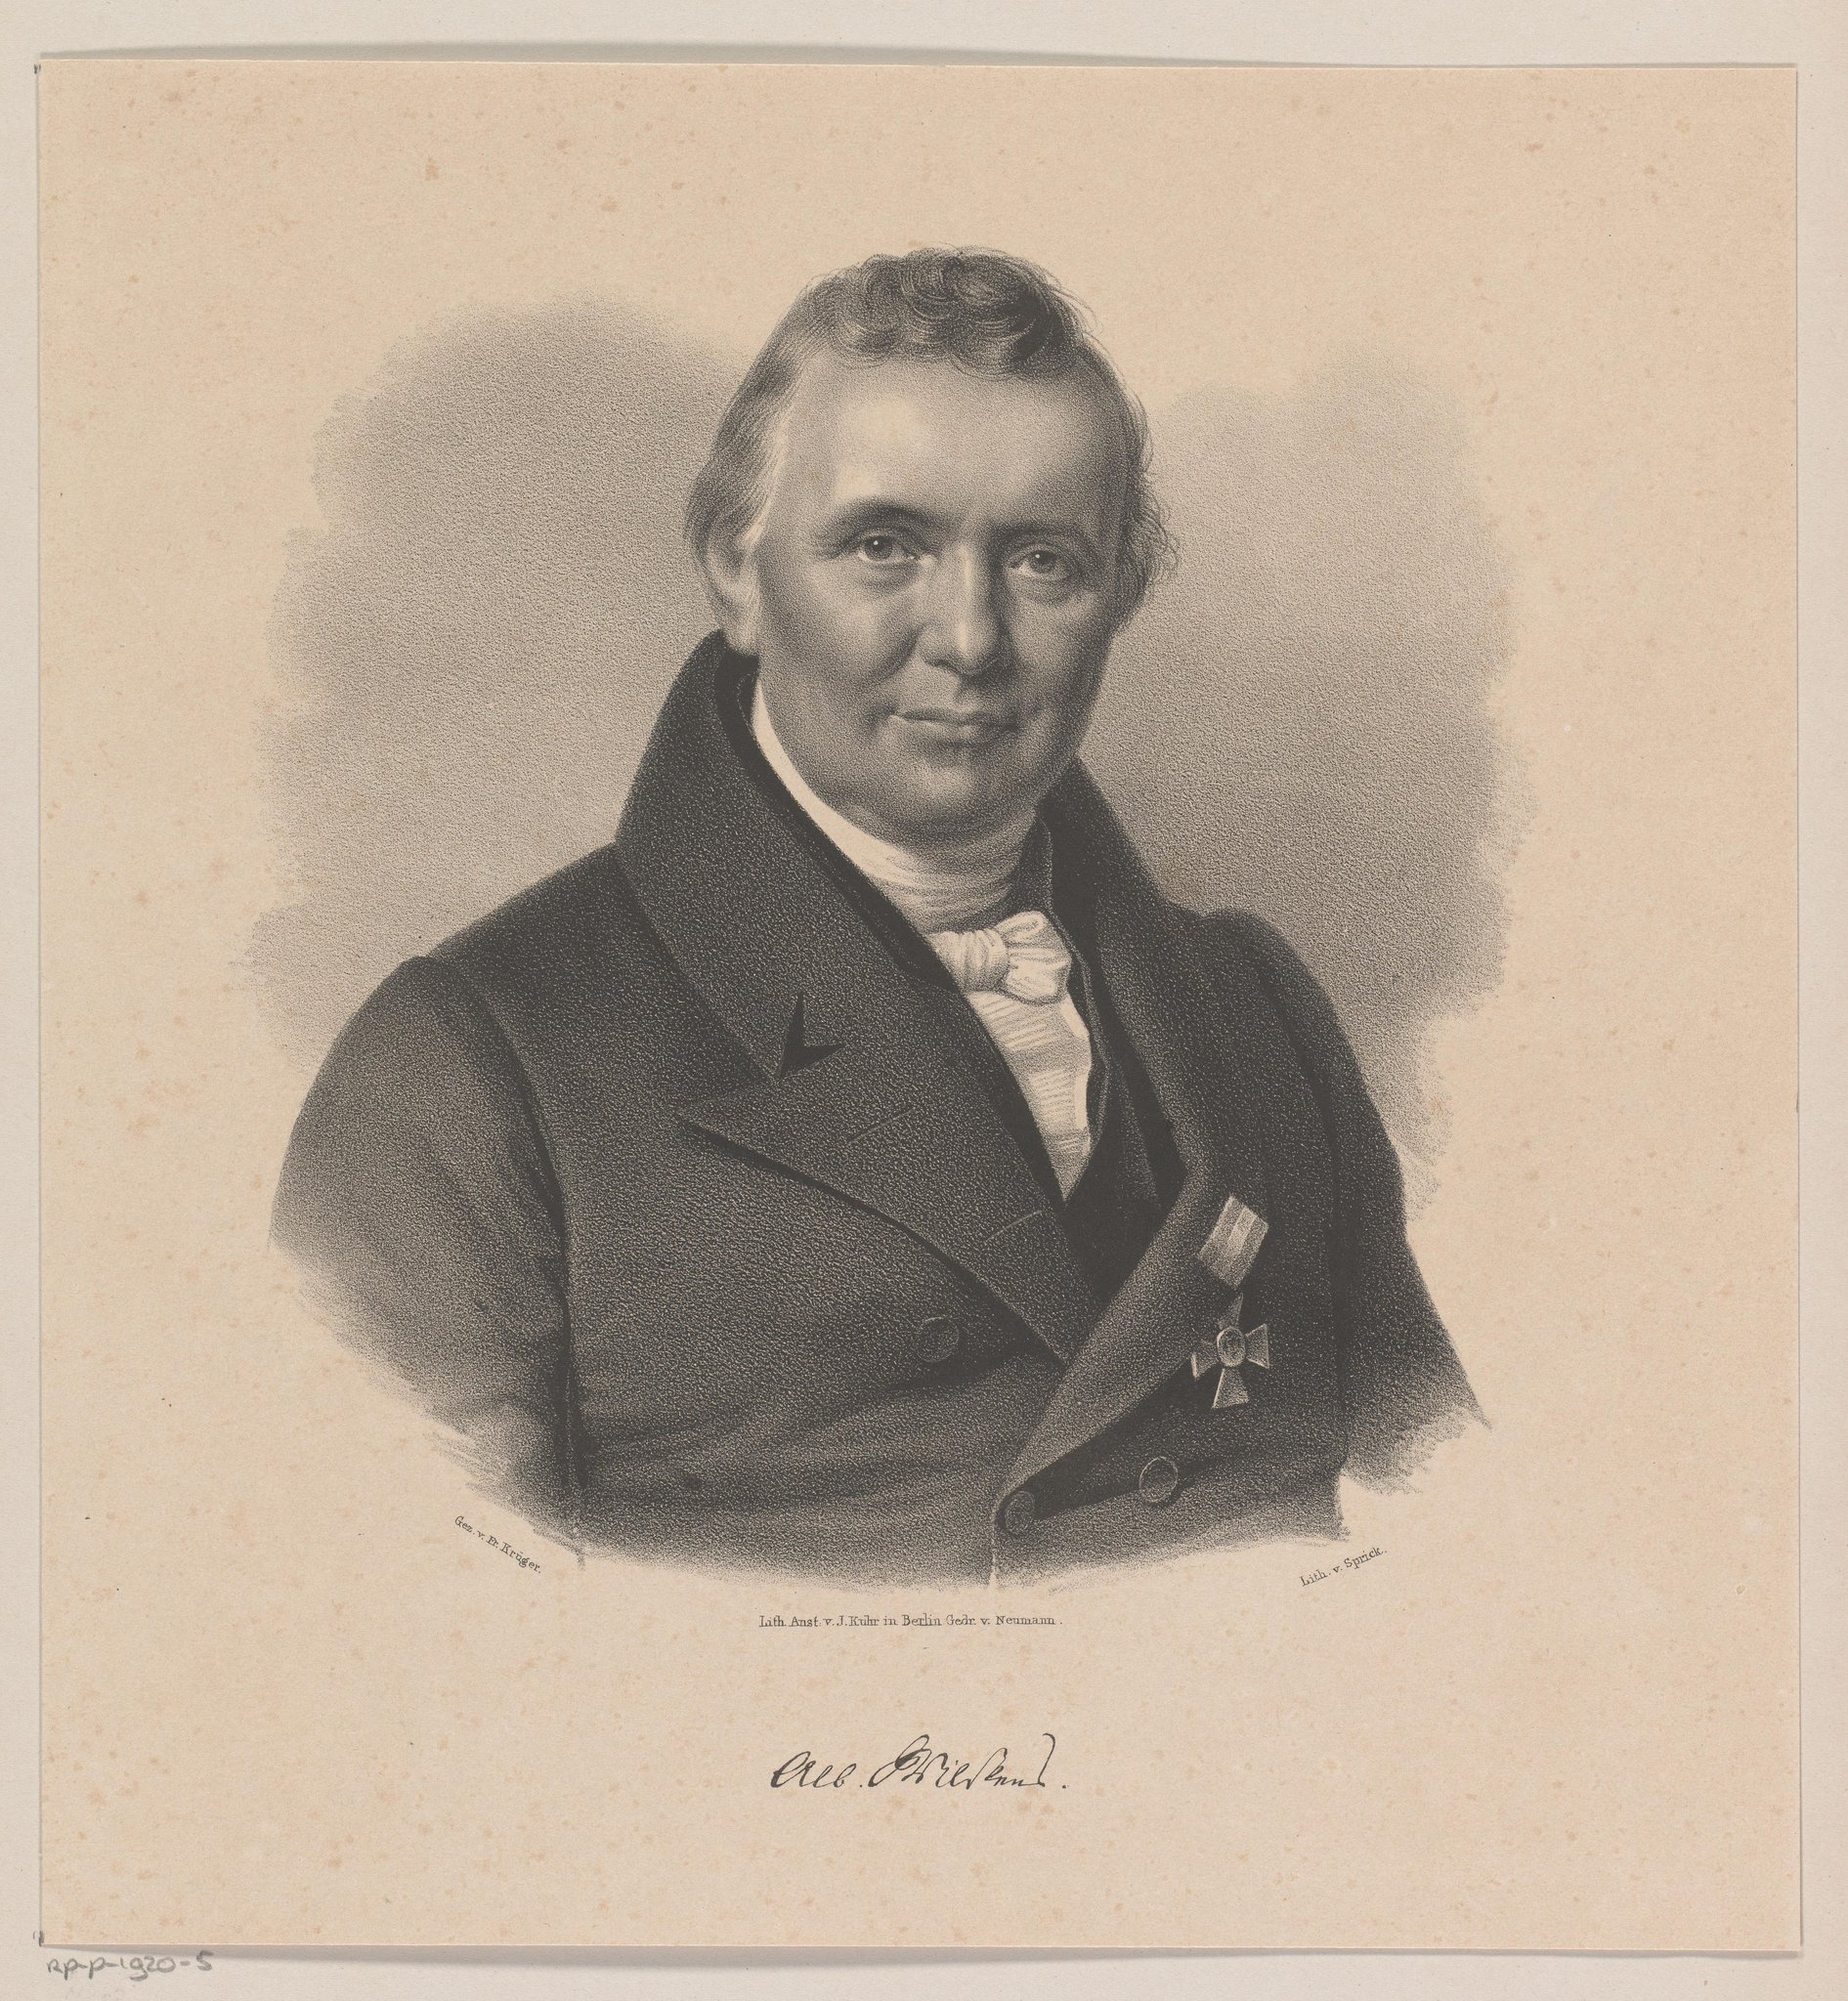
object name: print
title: Portret van Albert Wildens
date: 1820-1840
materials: paper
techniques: lithograph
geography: berlin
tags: historical persons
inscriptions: collector's mark: Lugt 2228